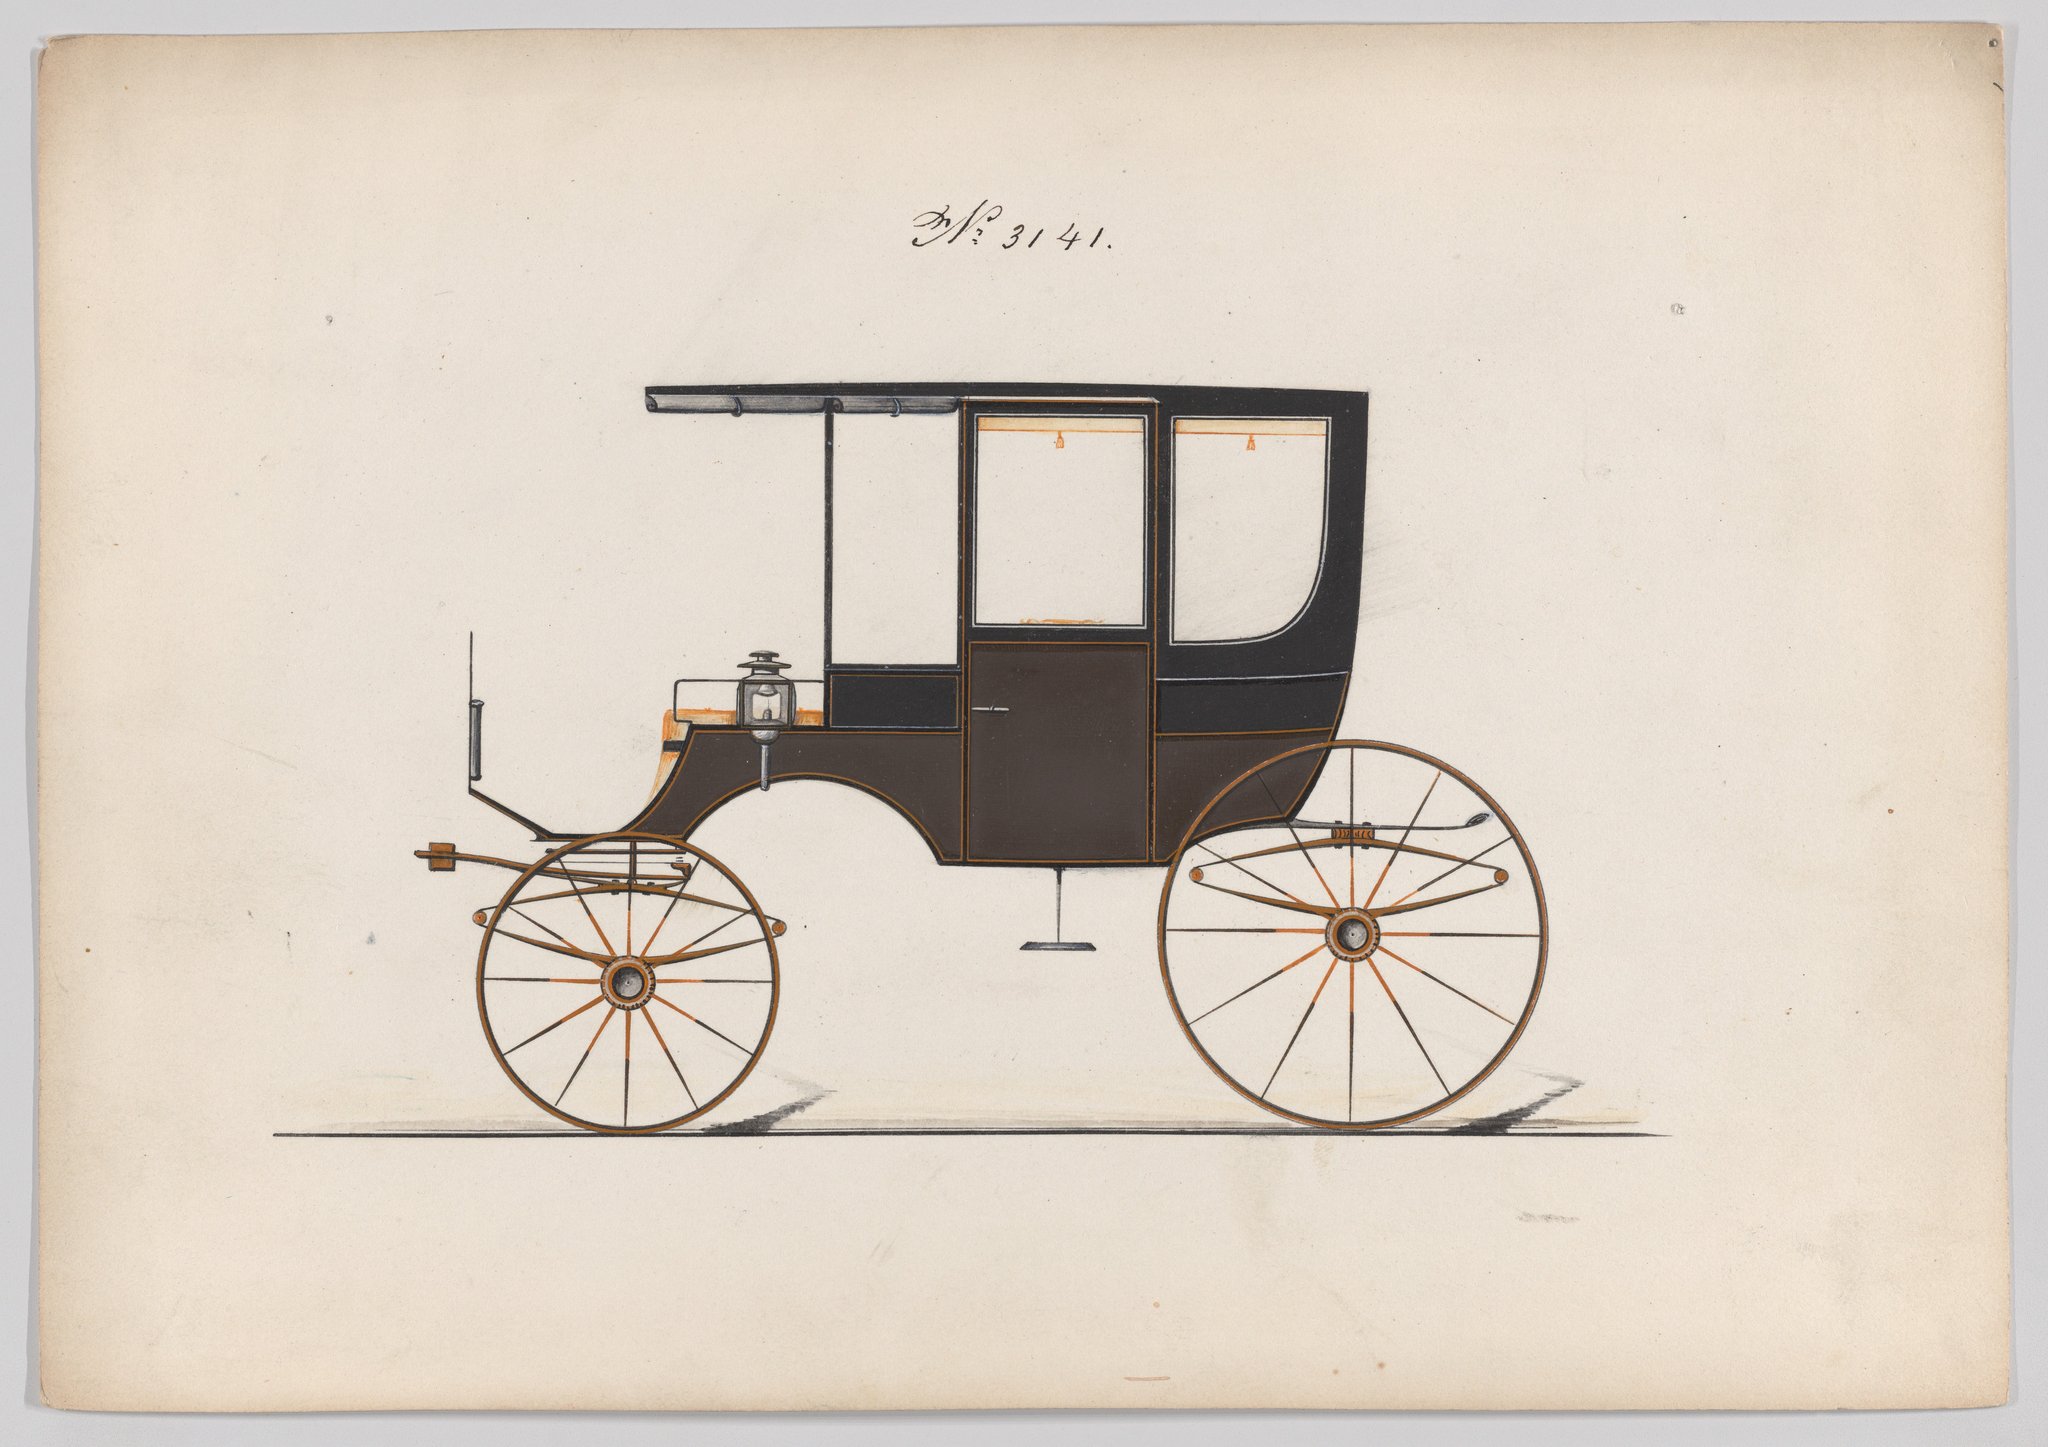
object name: drawing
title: Design for 6 seat Rockaway, no. 3141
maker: brewster & co.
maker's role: manufacturer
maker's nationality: american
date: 1875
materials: gouache, gum arabic, ink, watercolor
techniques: pen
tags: carriages